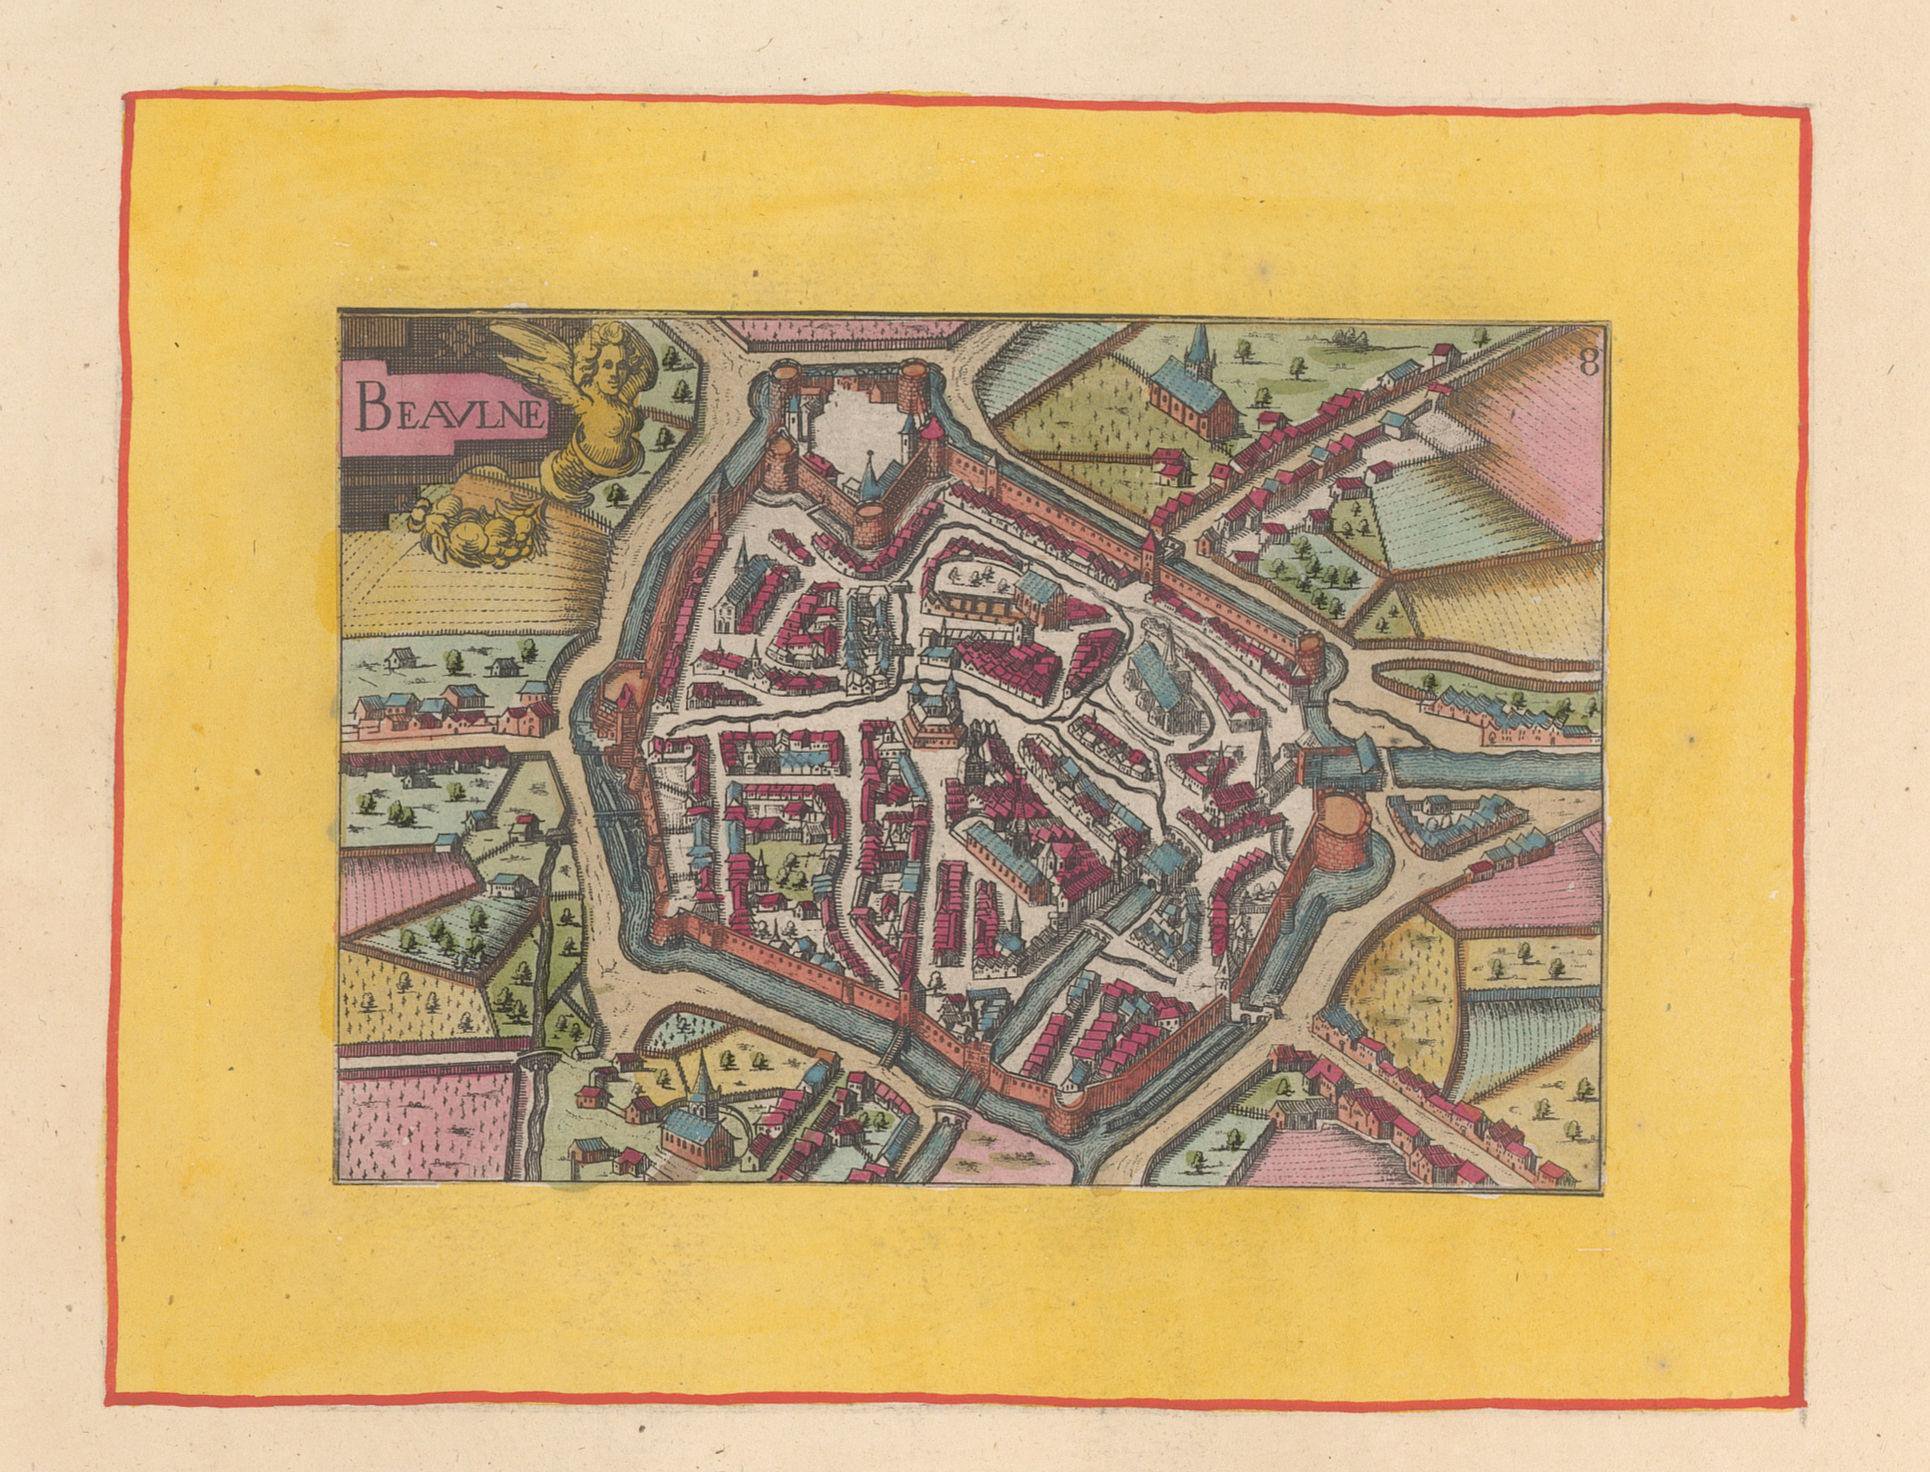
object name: area plan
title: Plattegrond van Beaune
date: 1638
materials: paper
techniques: engraving, etching, hand coloring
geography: paris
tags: city-view in general; 'veduta'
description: Prent uit: Tassin, Christophe. Les plans et profils de toutes les principales villes et lieux considérables de France (...). Parijs: Michel van Lochom, 1638, prent nummer 8 in het deel 'Bourgongne'.